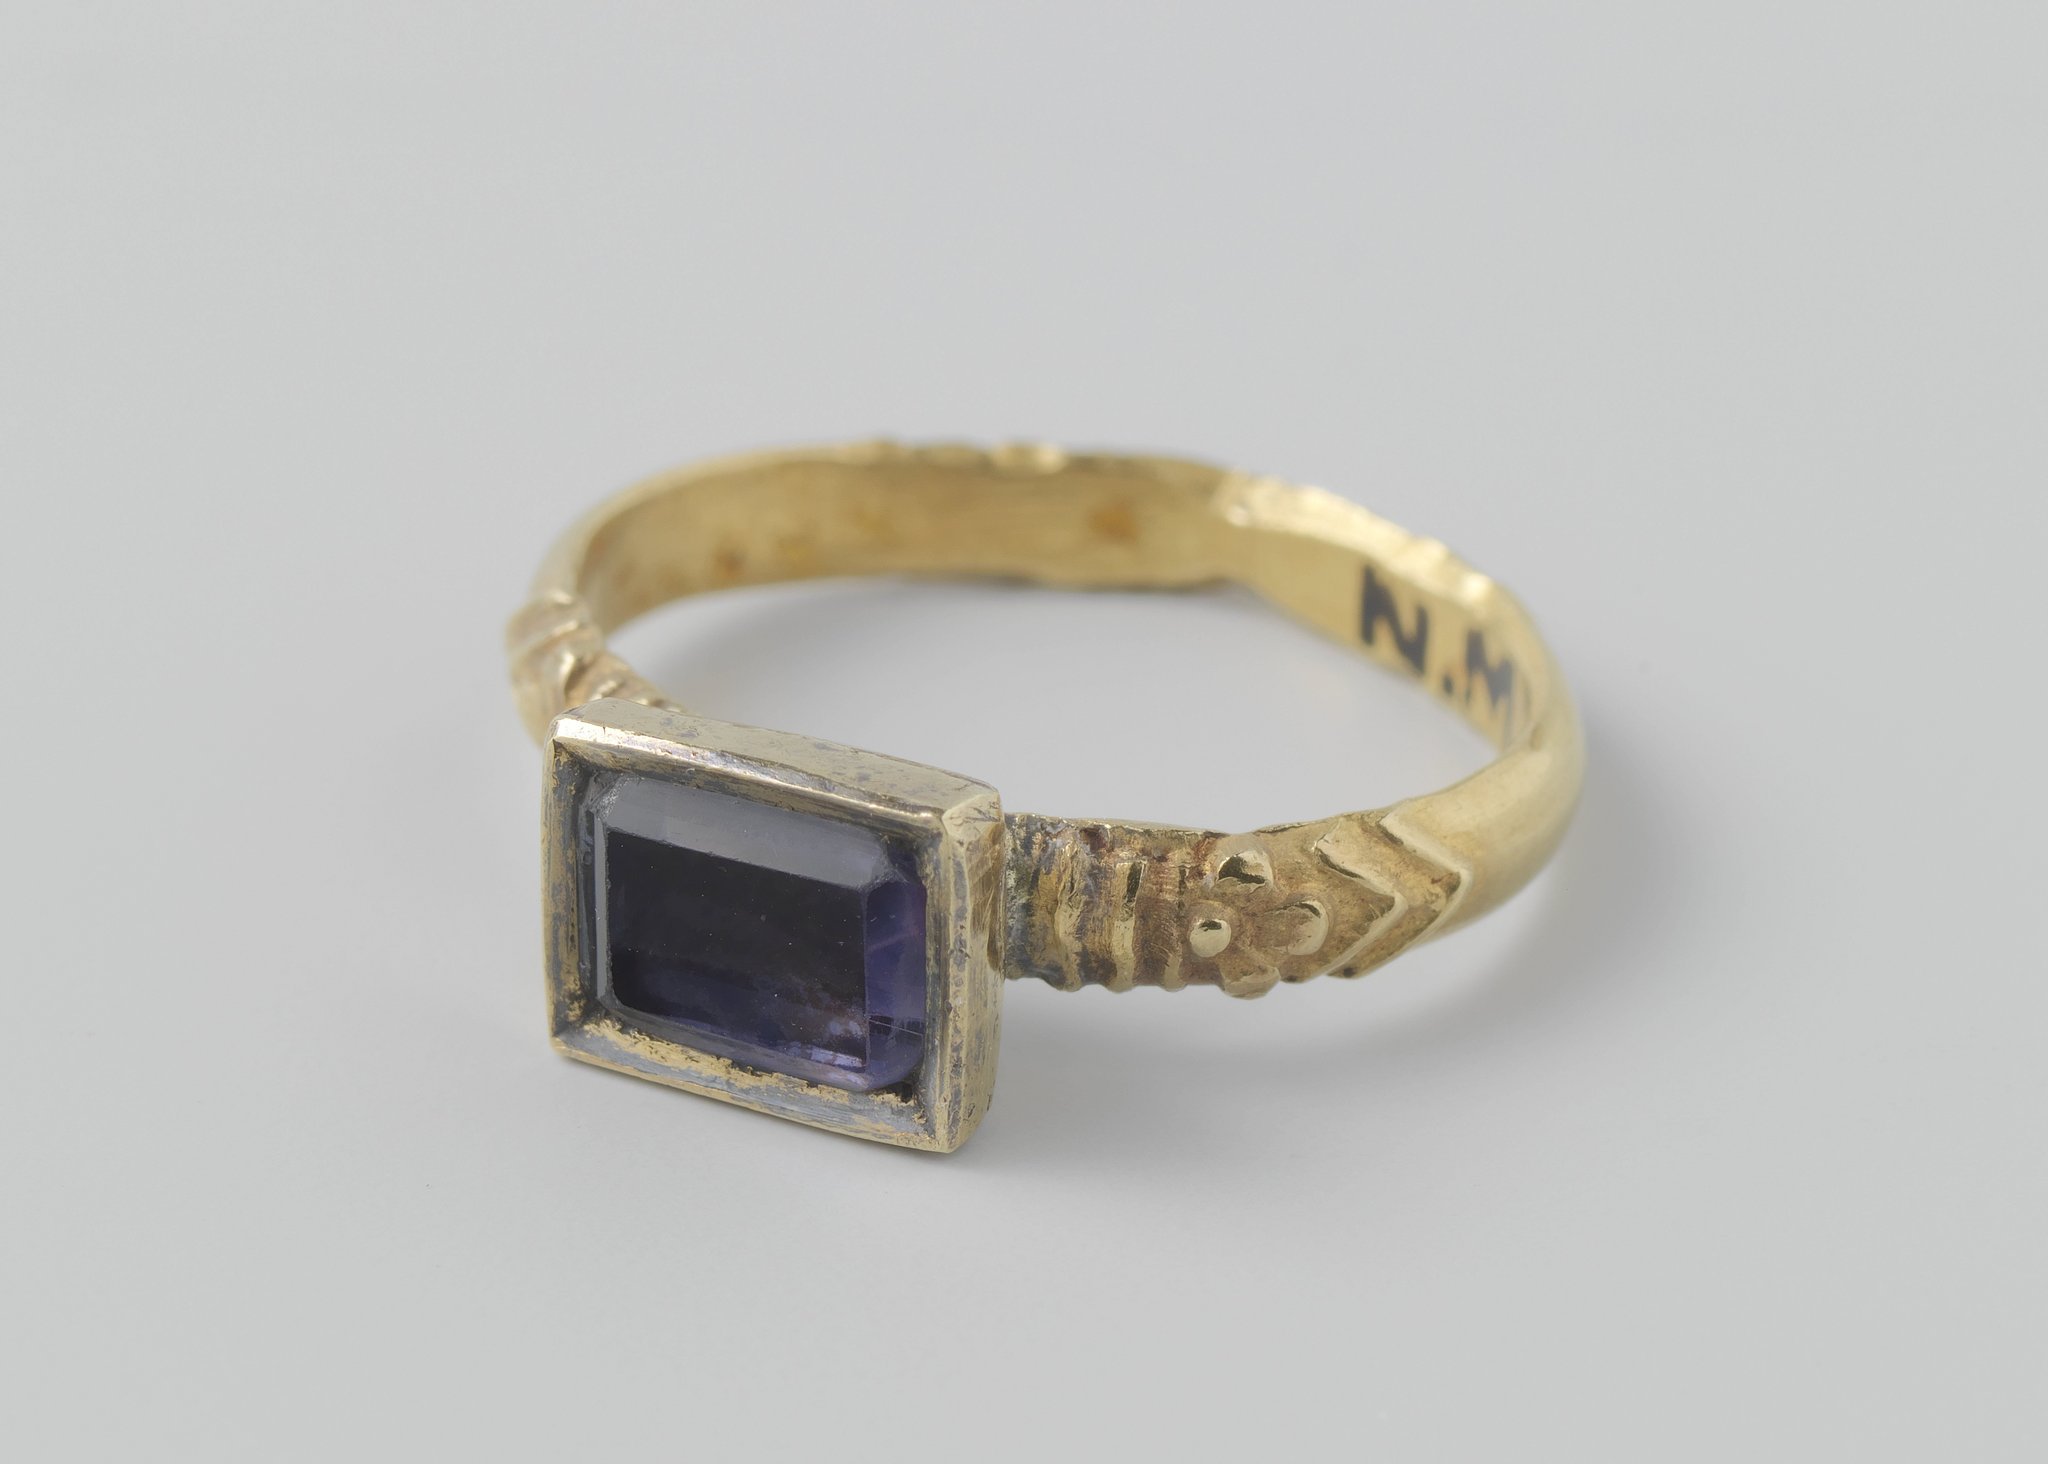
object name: ring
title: Finger ring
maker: Anonymous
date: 1750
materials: gold, gemstone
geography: surat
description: Vingerring van goud met een vierkante, blauwe steen.